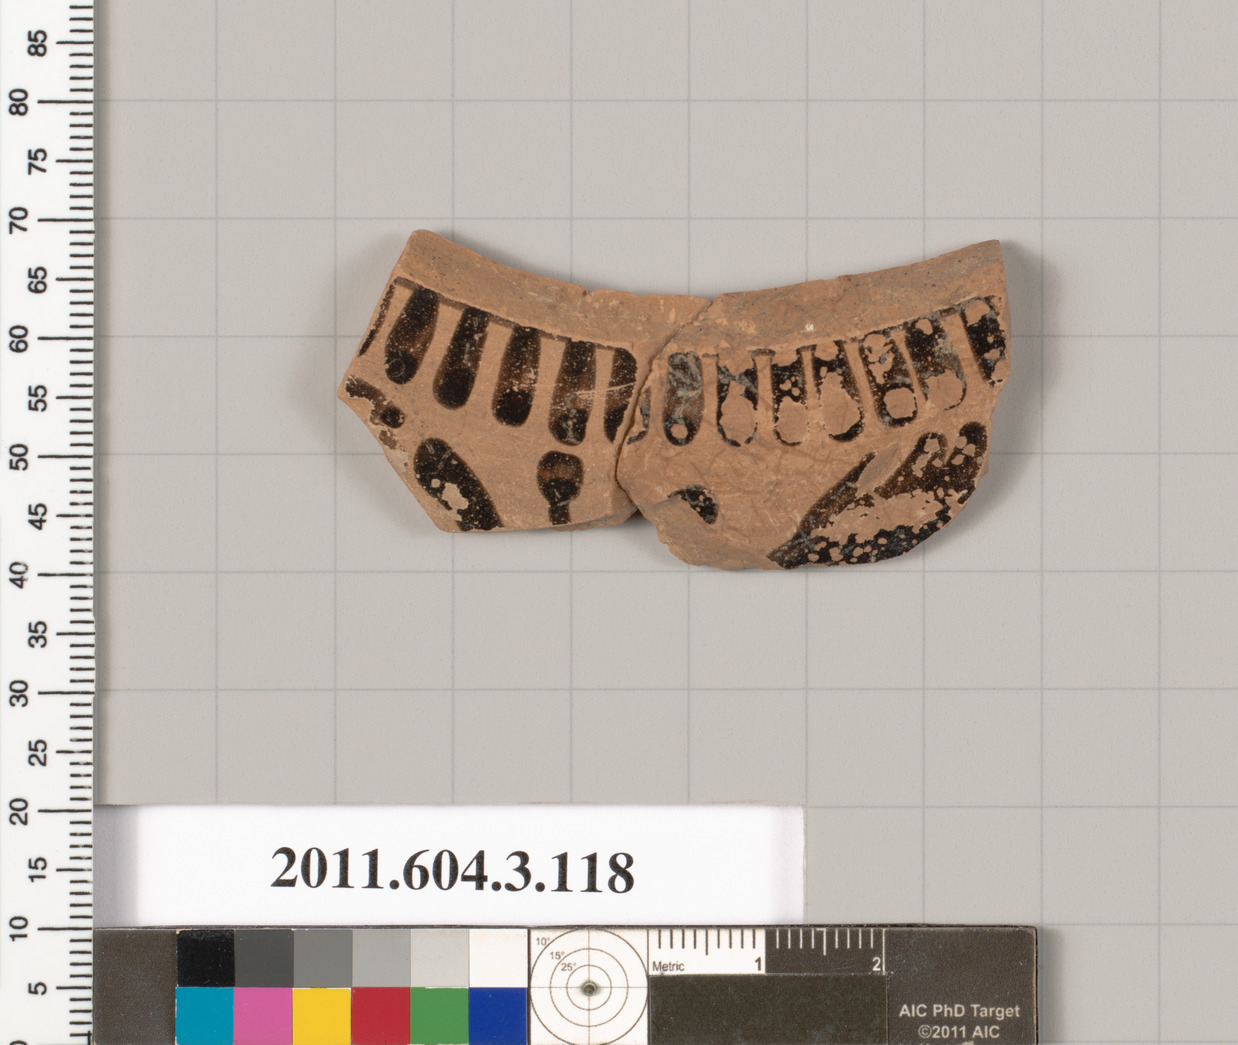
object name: amphora fragment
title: Terracotta fragment of an amphora (jar)?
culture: greek, attic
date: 534-468 BCE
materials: terracotta